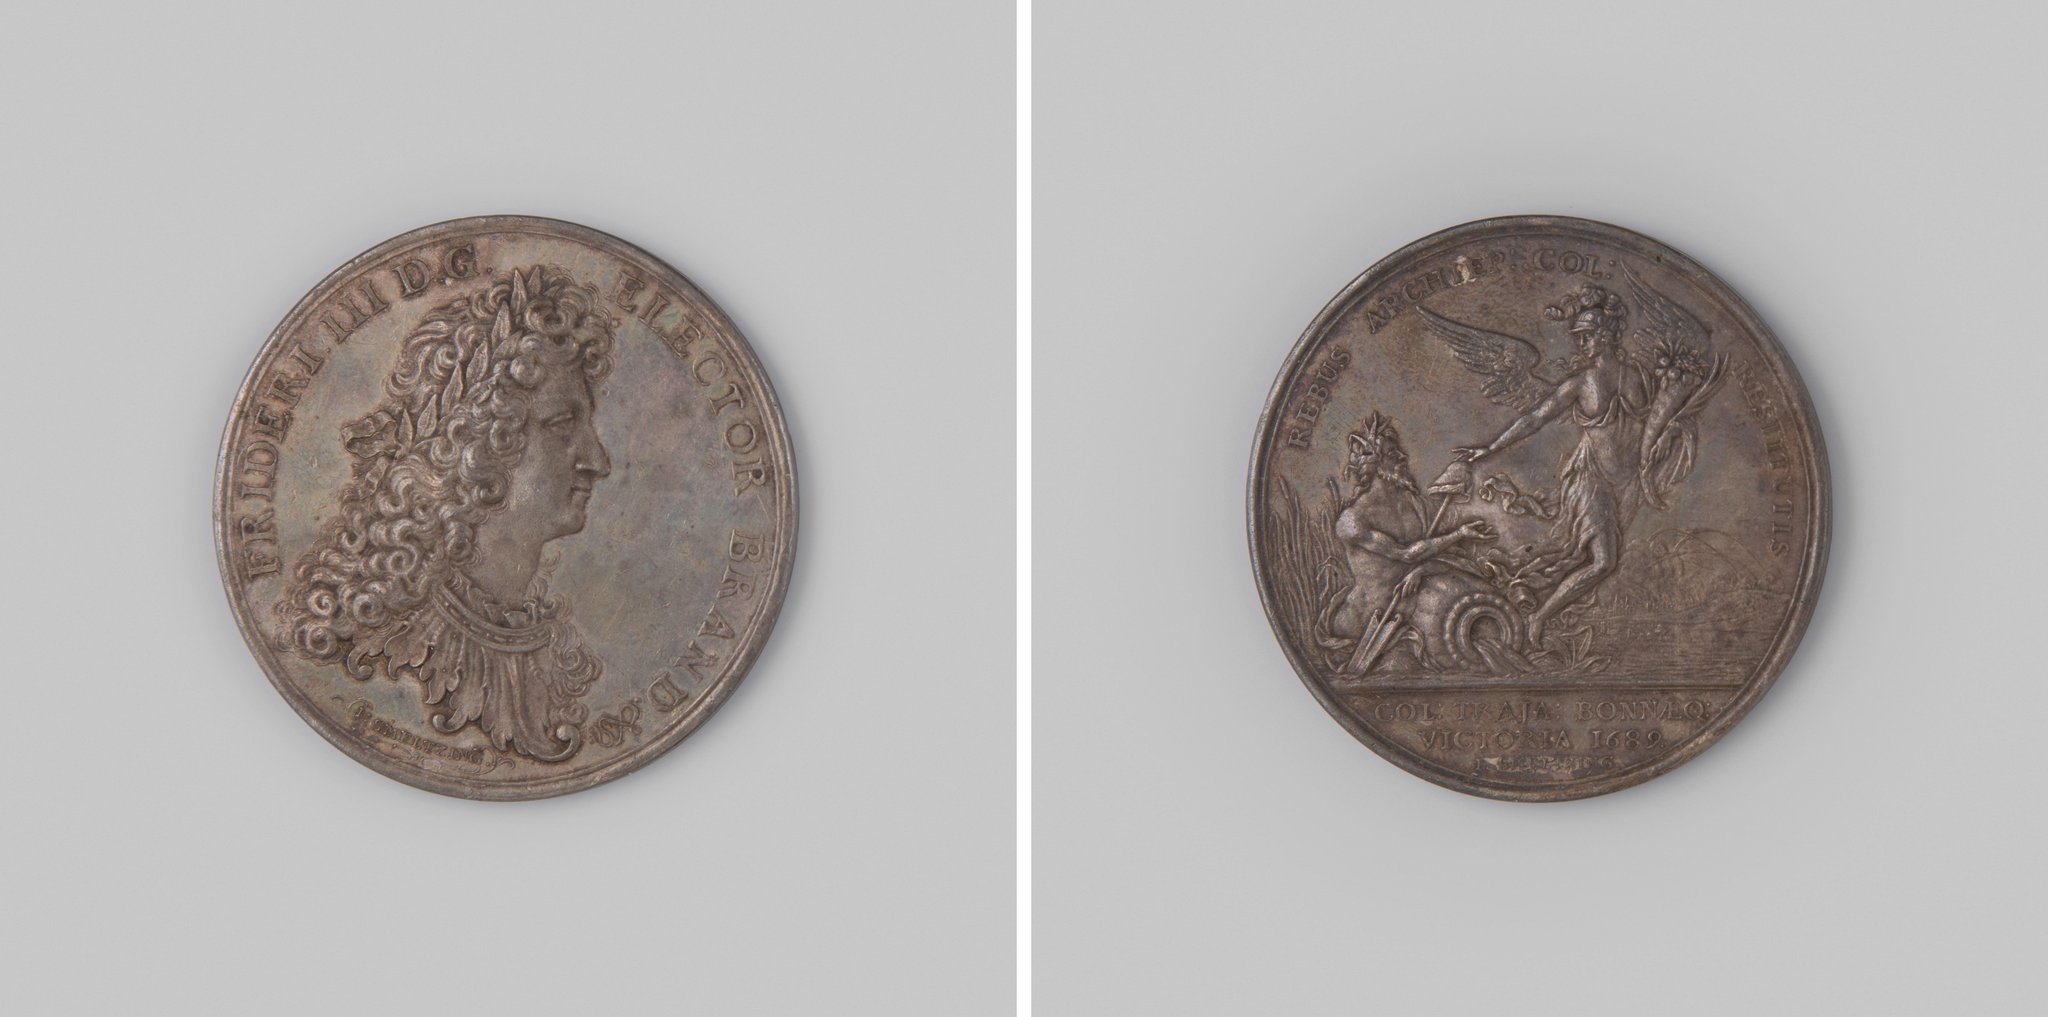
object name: honorary medal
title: Inname van Kaiserswerth en Bonn, ter ere van Frederik III, keurvorst van Brandenburg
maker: jan smeltzing (i)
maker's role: modelleur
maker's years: 1656-1693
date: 1689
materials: silver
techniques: striking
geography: leiden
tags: berlin, frederik i koning van pruisen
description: Zilveren penning. Voorzijde: borststuk man met lauwerkrans binnen omschrift. Keerzijde: gevleugelde, gehelmde Overwinning met hoorn van overvloed reikt vrijheidshoed aan Rijn binnen omschrift; afsnede: opschrift.